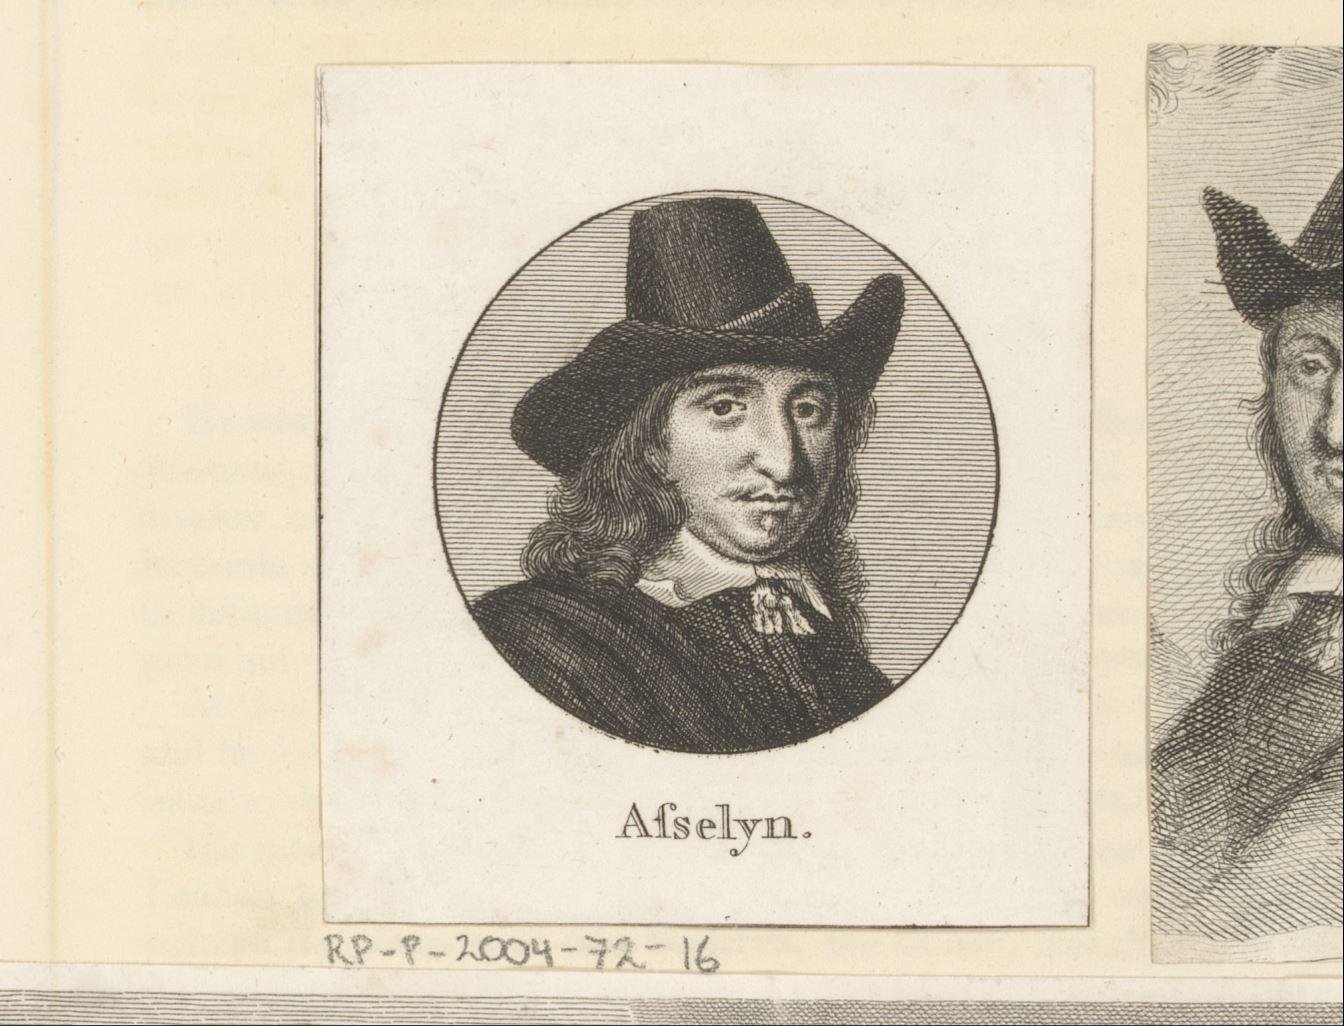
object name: album leaf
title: Portret van Jan Asselijn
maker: j.l.l.c. zentner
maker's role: print maker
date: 1791-1800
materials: paper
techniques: etching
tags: draughtsman, jan asselijn, historical persons, portrait, self-portrait of painter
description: De samensteller heeft deze prent in het album geplakt als illustratie bij: Pilkington, Matthew en Johann Heinrich Füssli. A dictionary of painters, from the revival of the art to the present period. 4 dln. Londen: John Crowder, 1805, dl. 1, p. 18.